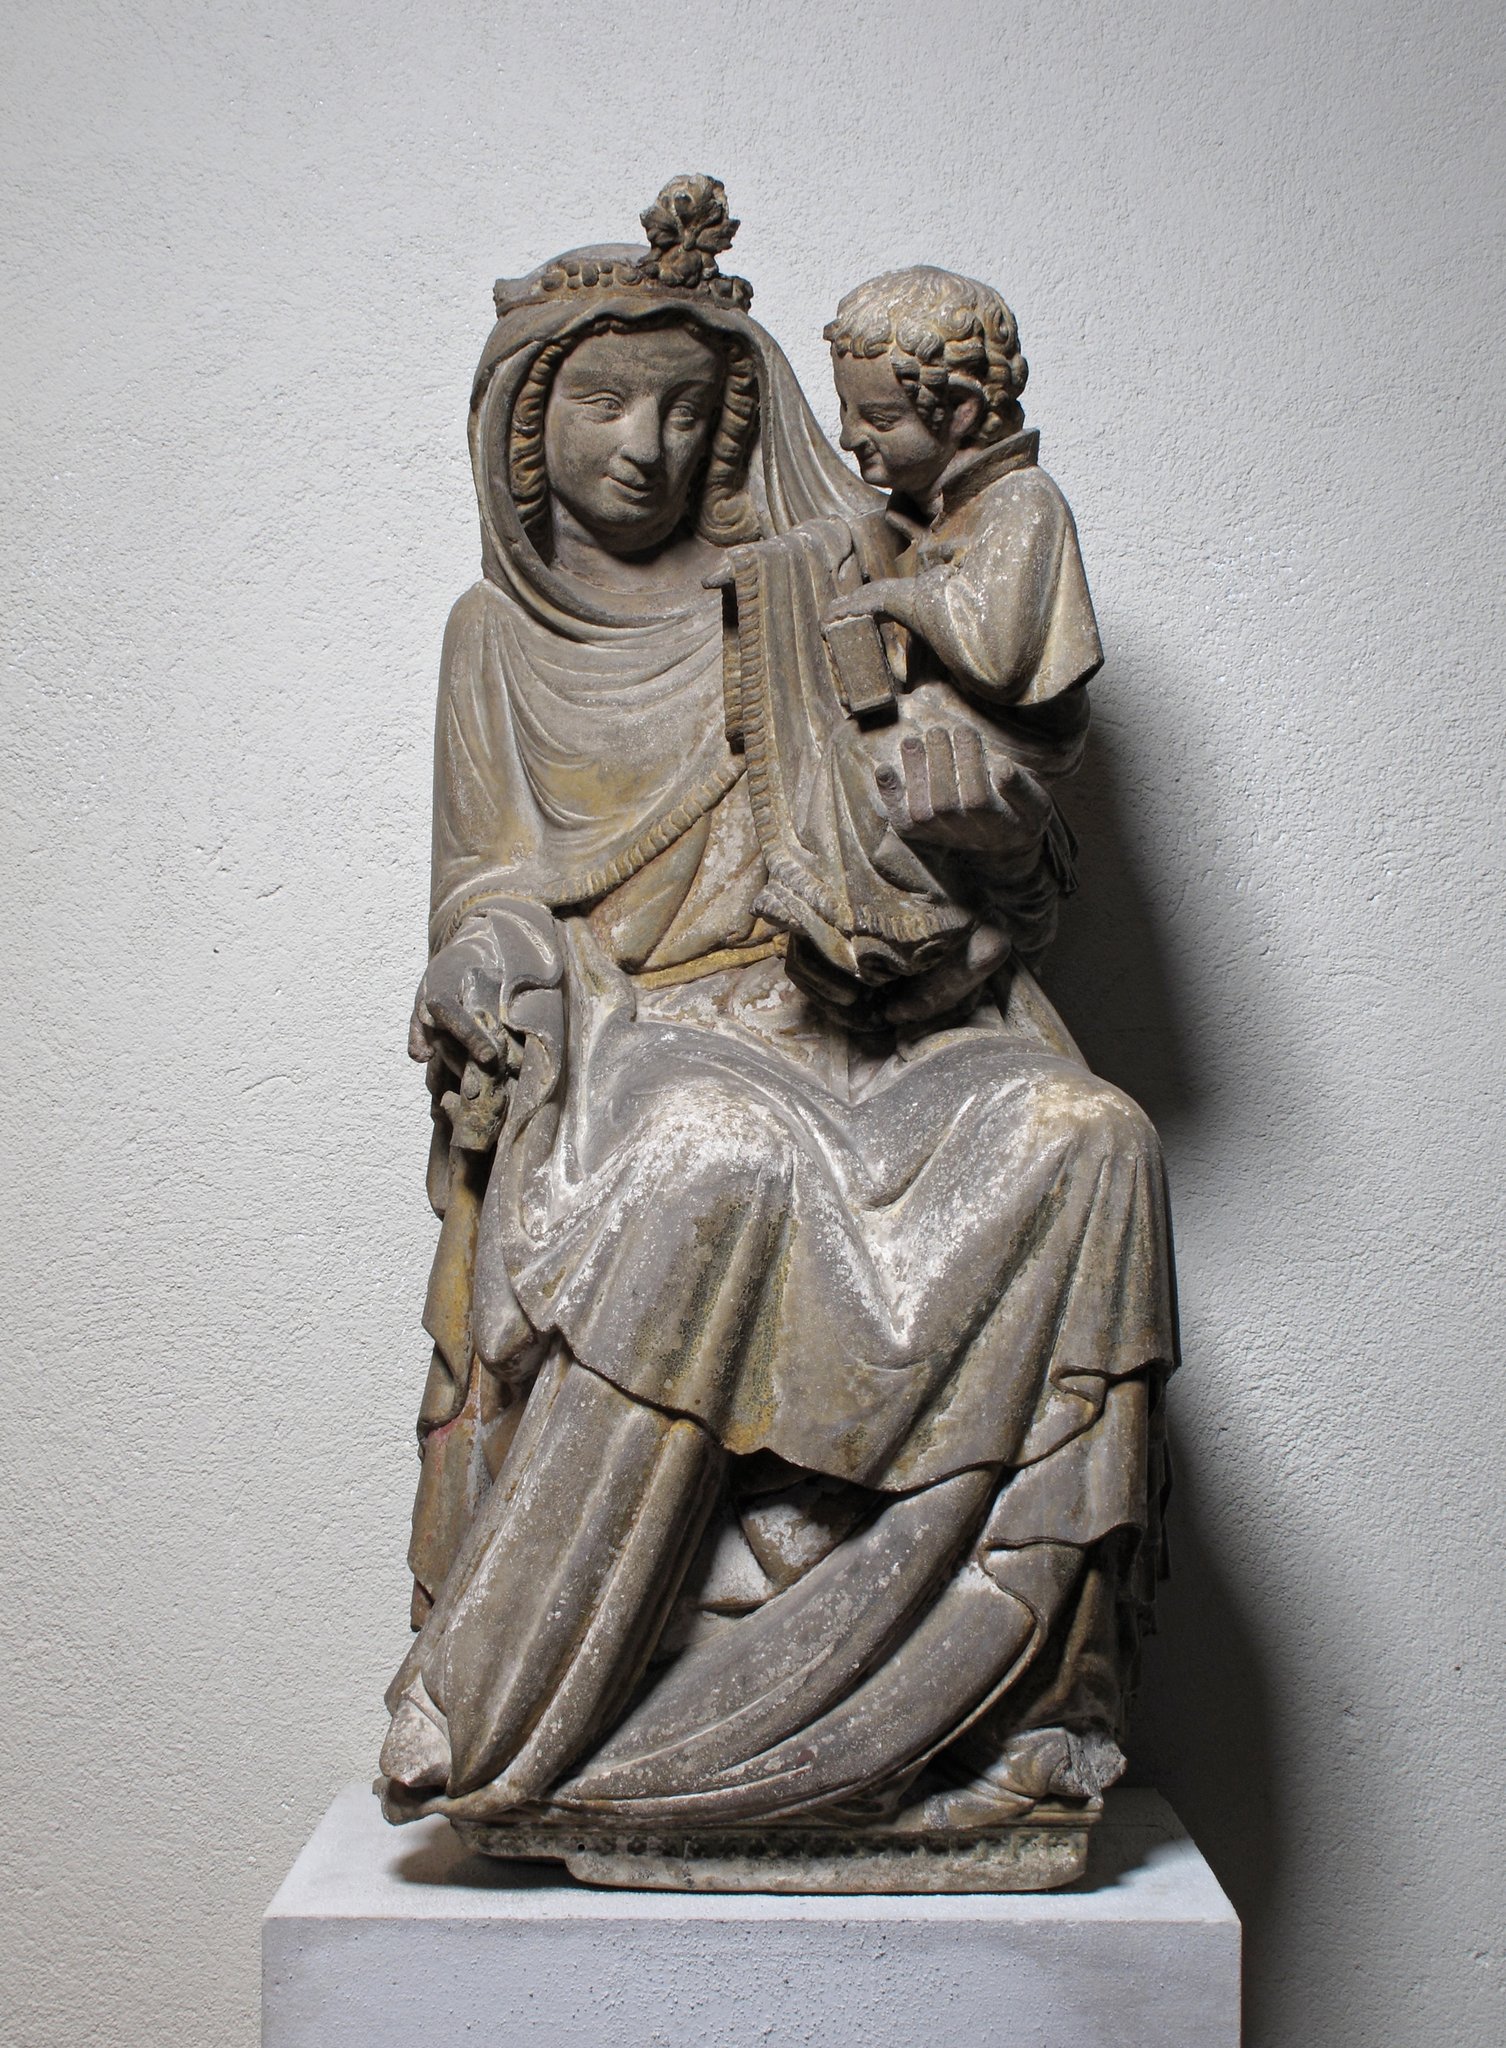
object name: statue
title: Seated Virgin and Child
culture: german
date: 1351-1400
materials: stone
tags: madonna and child